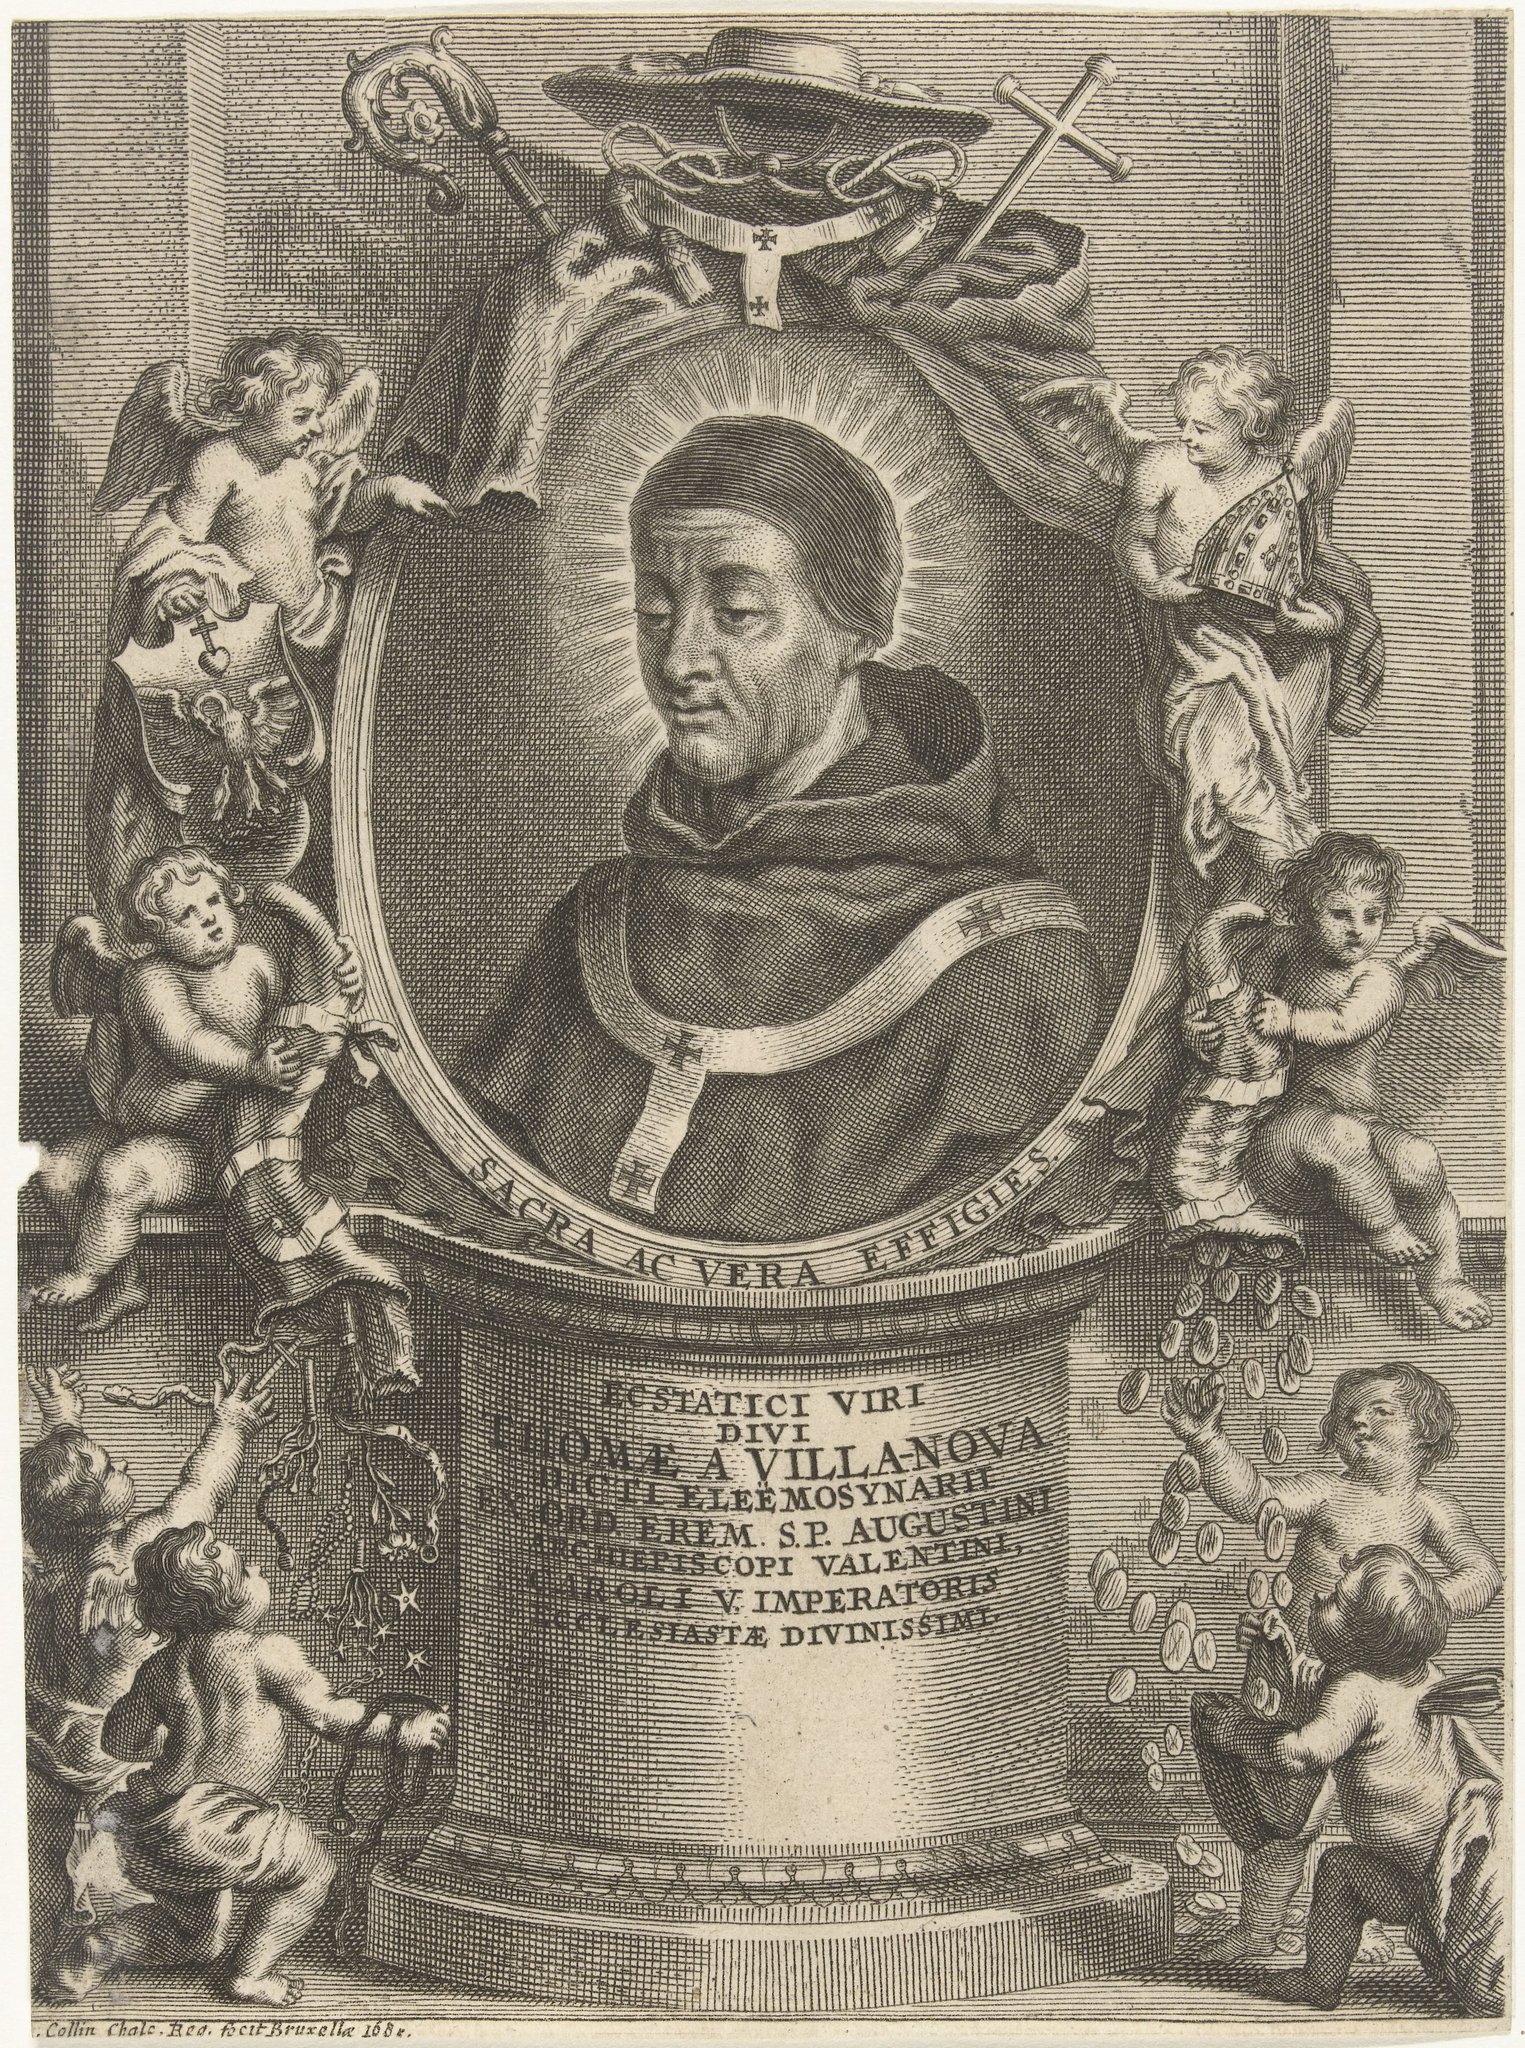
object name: print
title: St. Thomas van Villanova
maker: richard collin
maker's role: print maker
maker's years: 1627-1697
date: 1685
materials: paper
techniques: engraving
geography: brussels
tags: the augustinian friar thomas of villanueva, archbishop of valencia; possible attributes: beggars, cripples, purse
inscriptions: collector's mark: Lugt 2228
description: De heilige Thomas van Villanova, in ovaal met een omlijsting van engelen. Thomas stond ervoor bekend dat hij altijd zijn geld aan de armen gaf. In de omlijsting spelen de engelen met munten en martelwerktuigen. De engelen aan weerszijden van het portret houden een bisschopsmijter en een wapen.